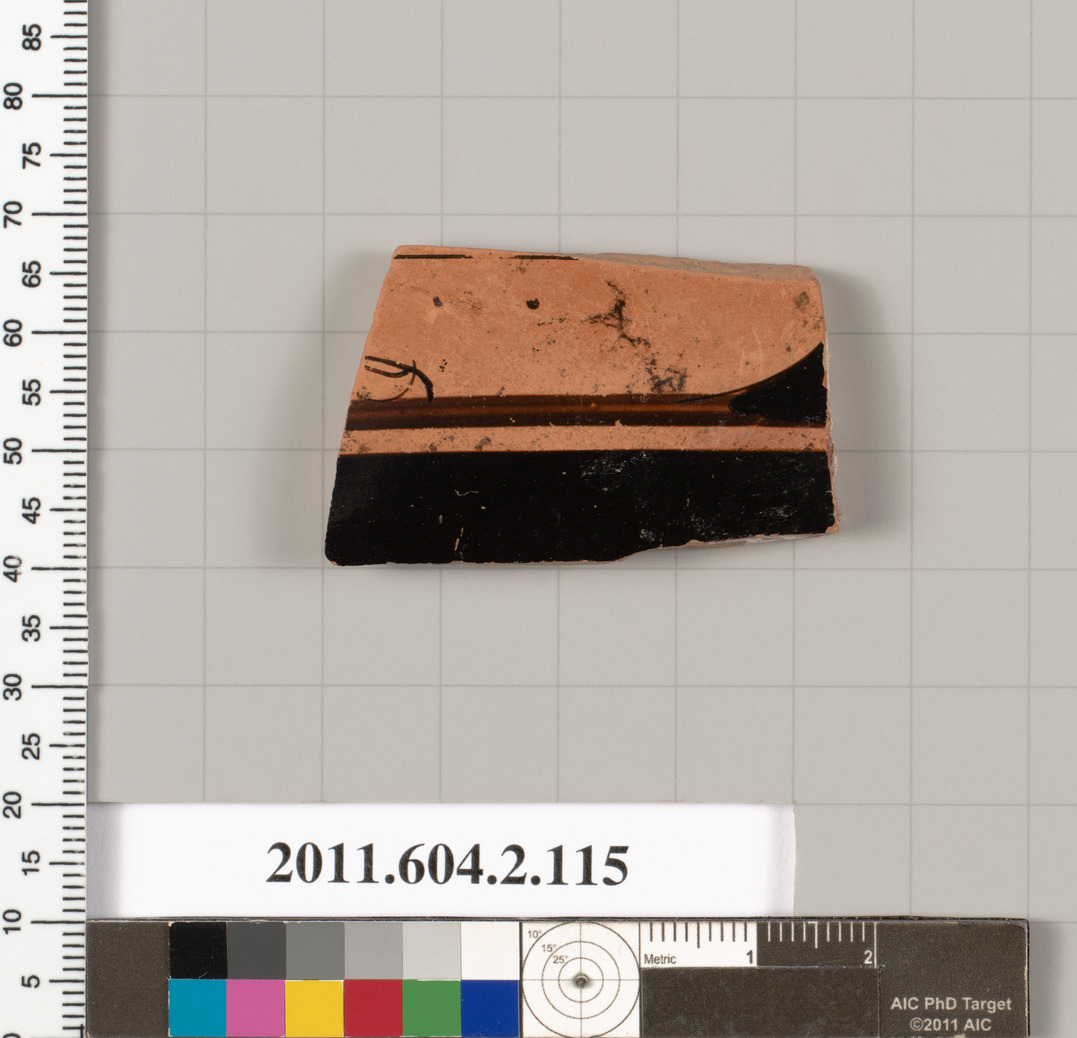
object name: pot fragment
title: Terracotta fragment of a pot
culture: greek, attic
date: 500-480 BCE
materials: terracotta